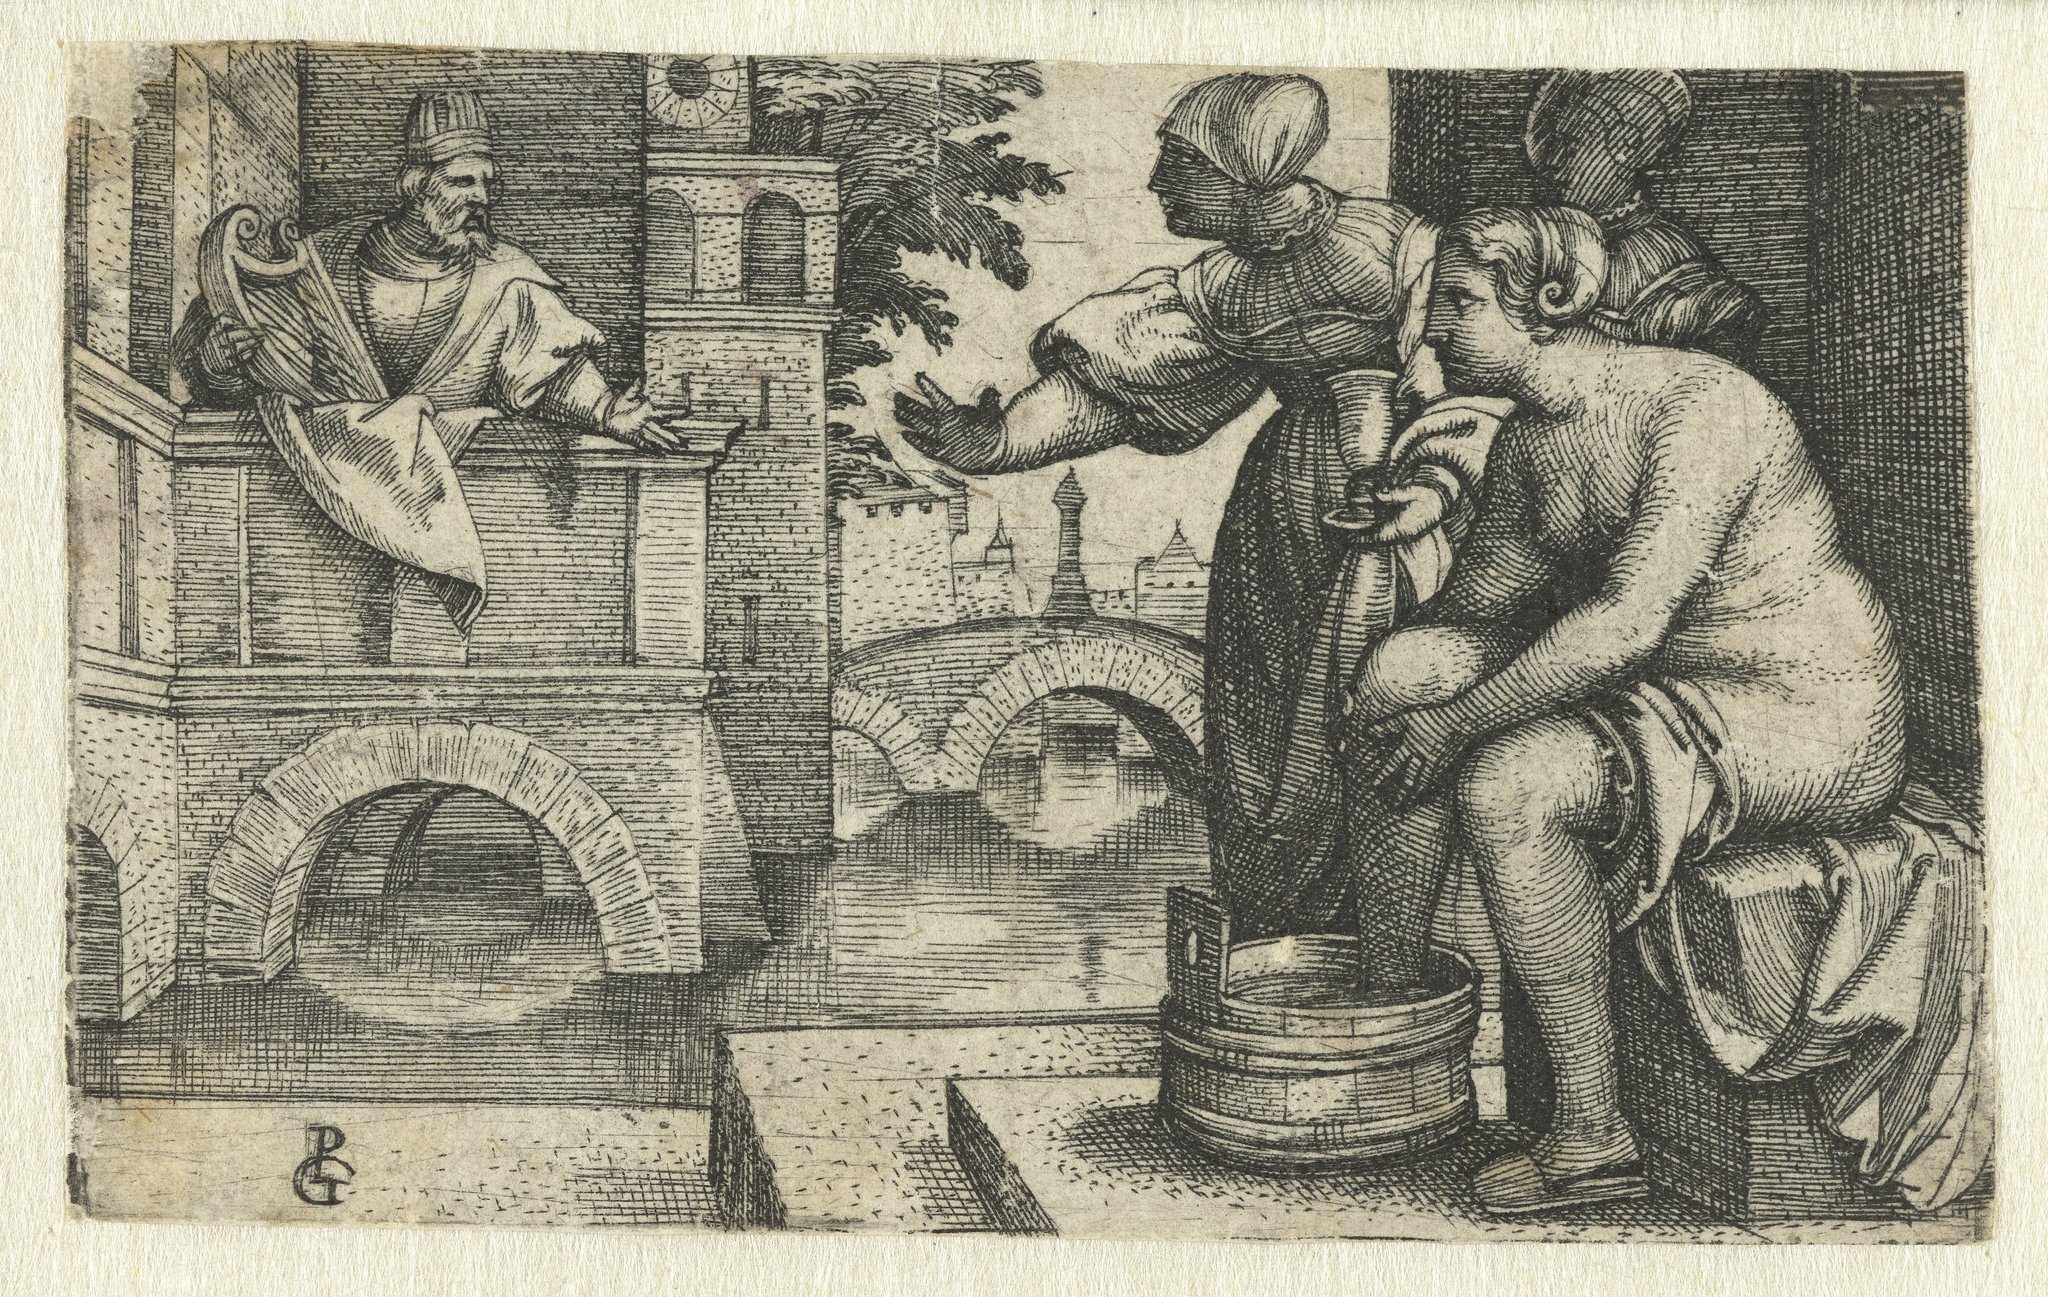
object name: print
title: David ziet Batseba in zijn tuin baden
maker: georg pencz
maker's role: draughtsman, painter, print maker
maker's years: 1500-1550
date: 1529-1533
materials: paper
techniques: engraving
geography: germany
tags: bathsheba attended by servant(s)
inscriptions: collector's mark: Lugt 240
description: Vanaf het balkon van zijn paleis ziet David, met een harp in zijn hand, de mooie Batseba een bad nemen in zijn tuin. Zij wordt geholpen door twee bedienden.